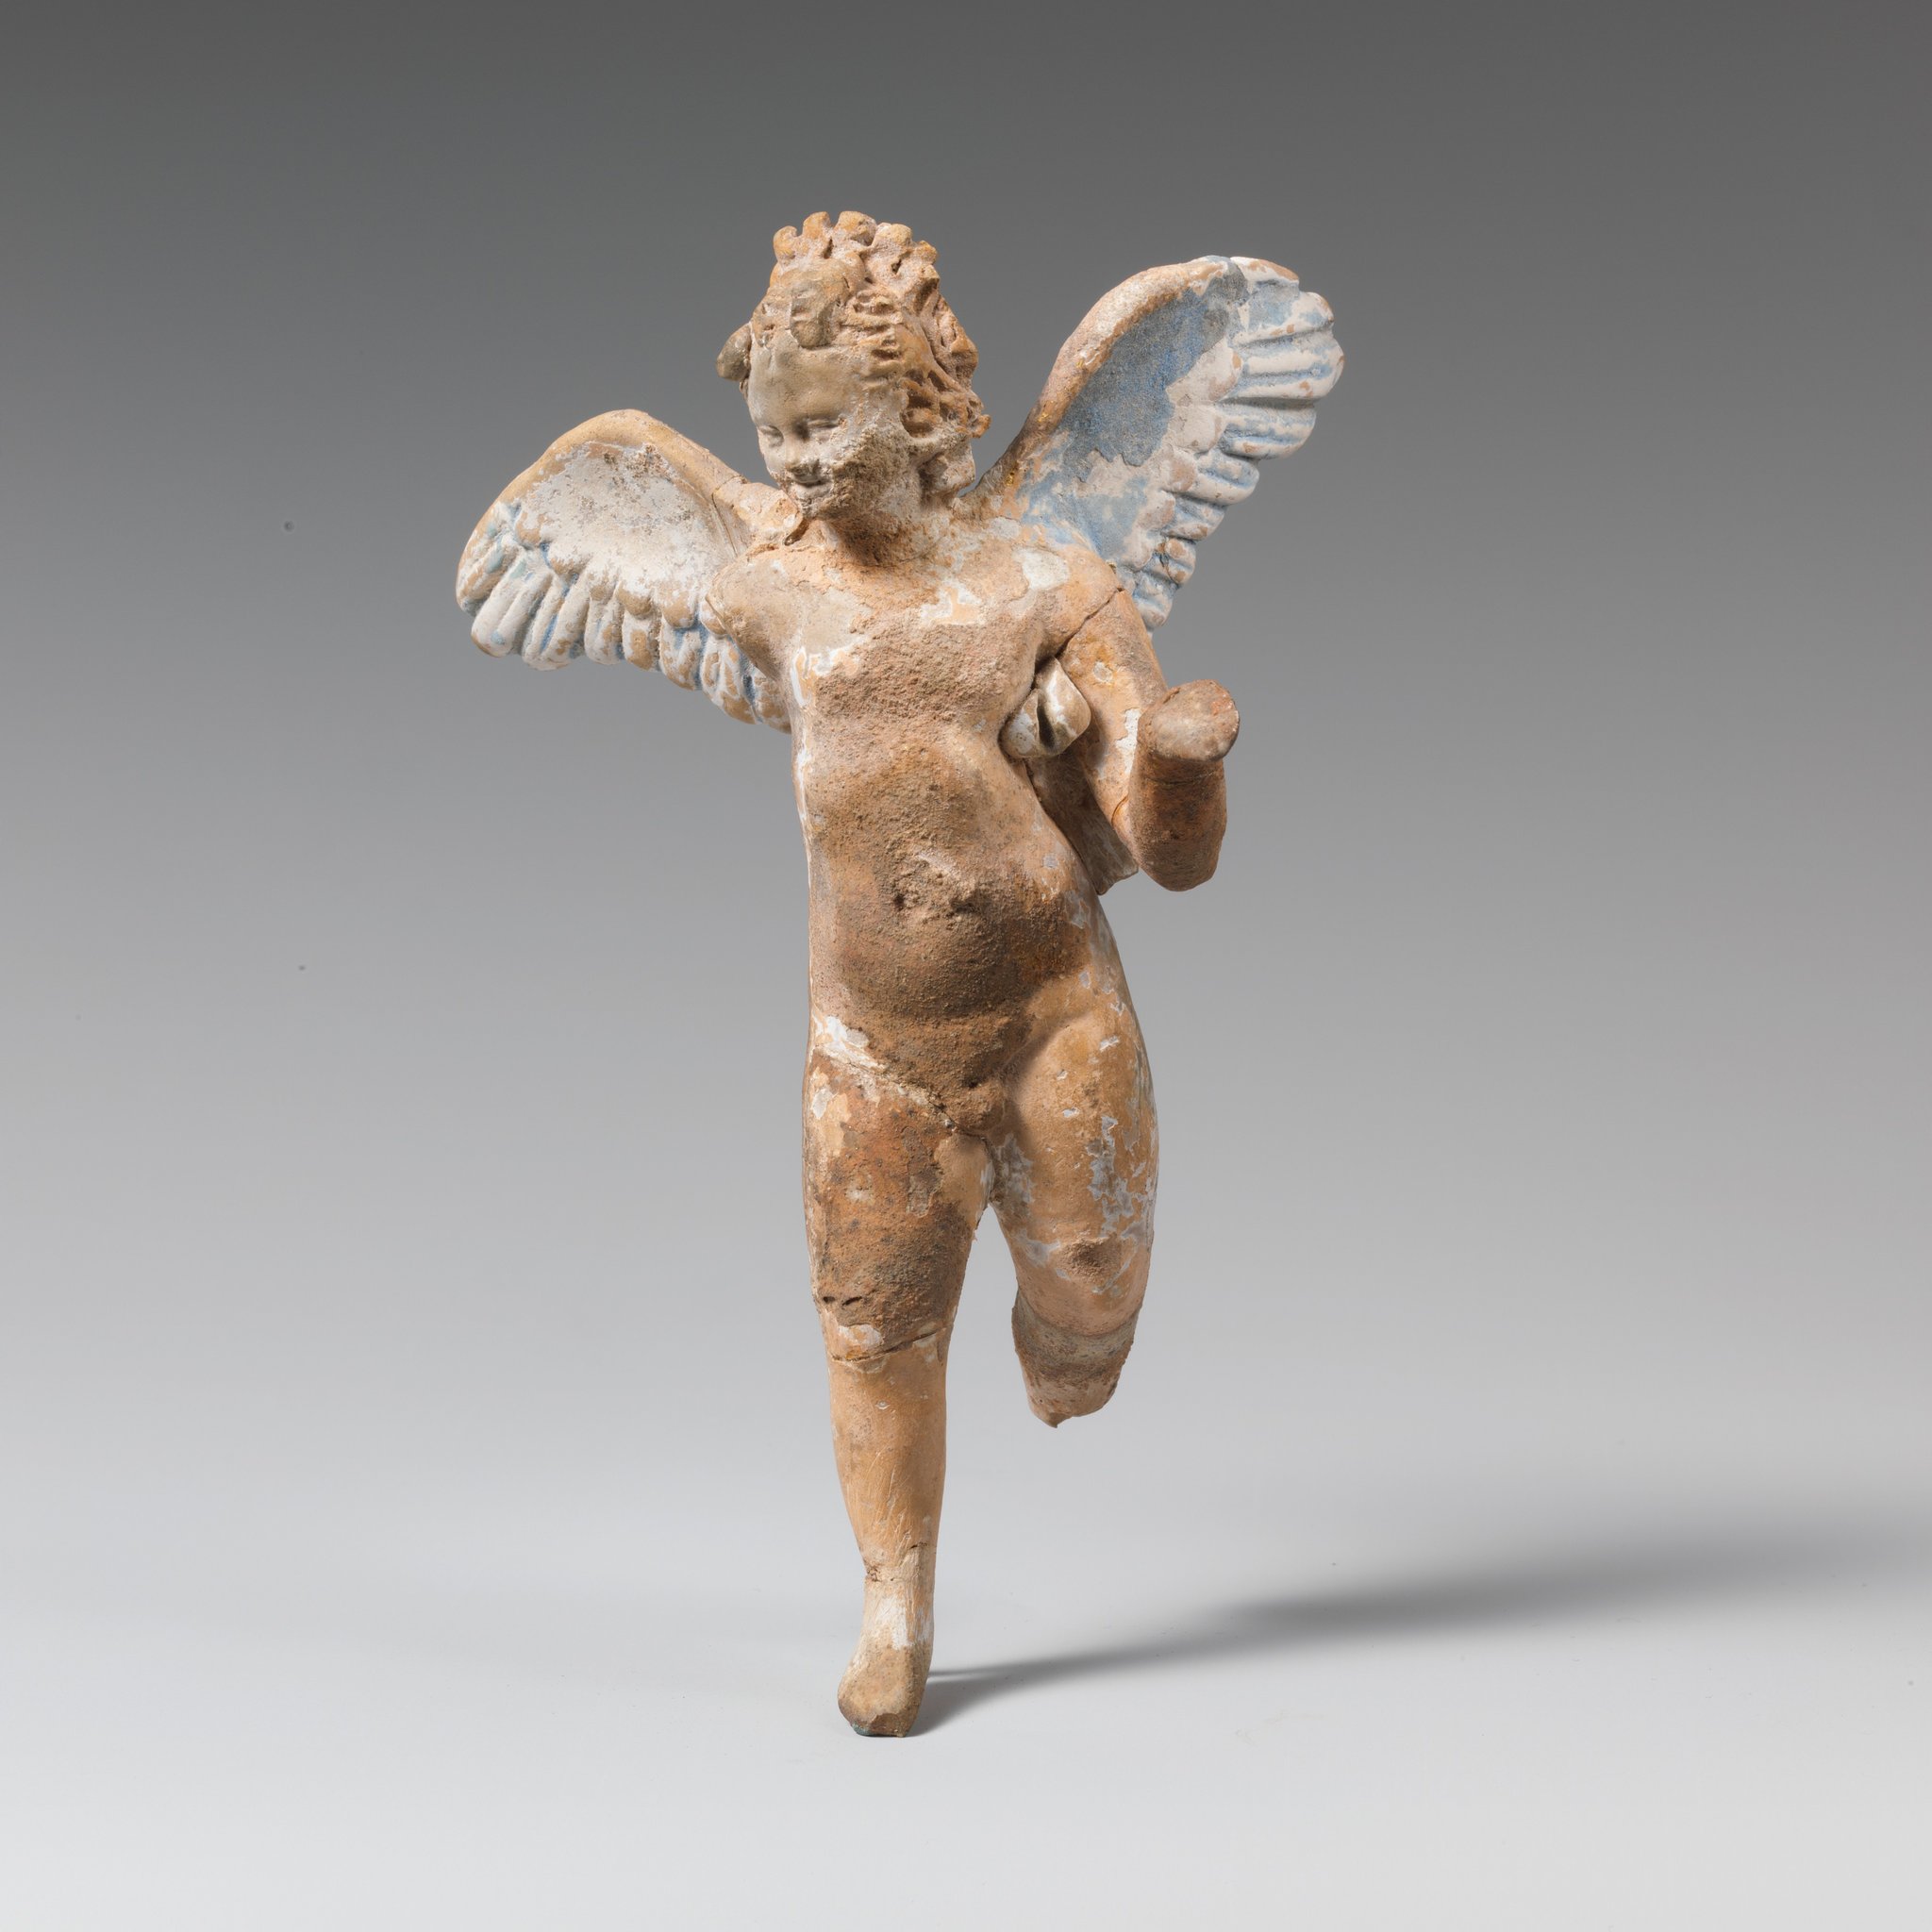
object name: statuette of eros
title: Terracotta statuette of Eros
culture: greek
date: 300-201 BCE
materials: terracotta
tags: eros